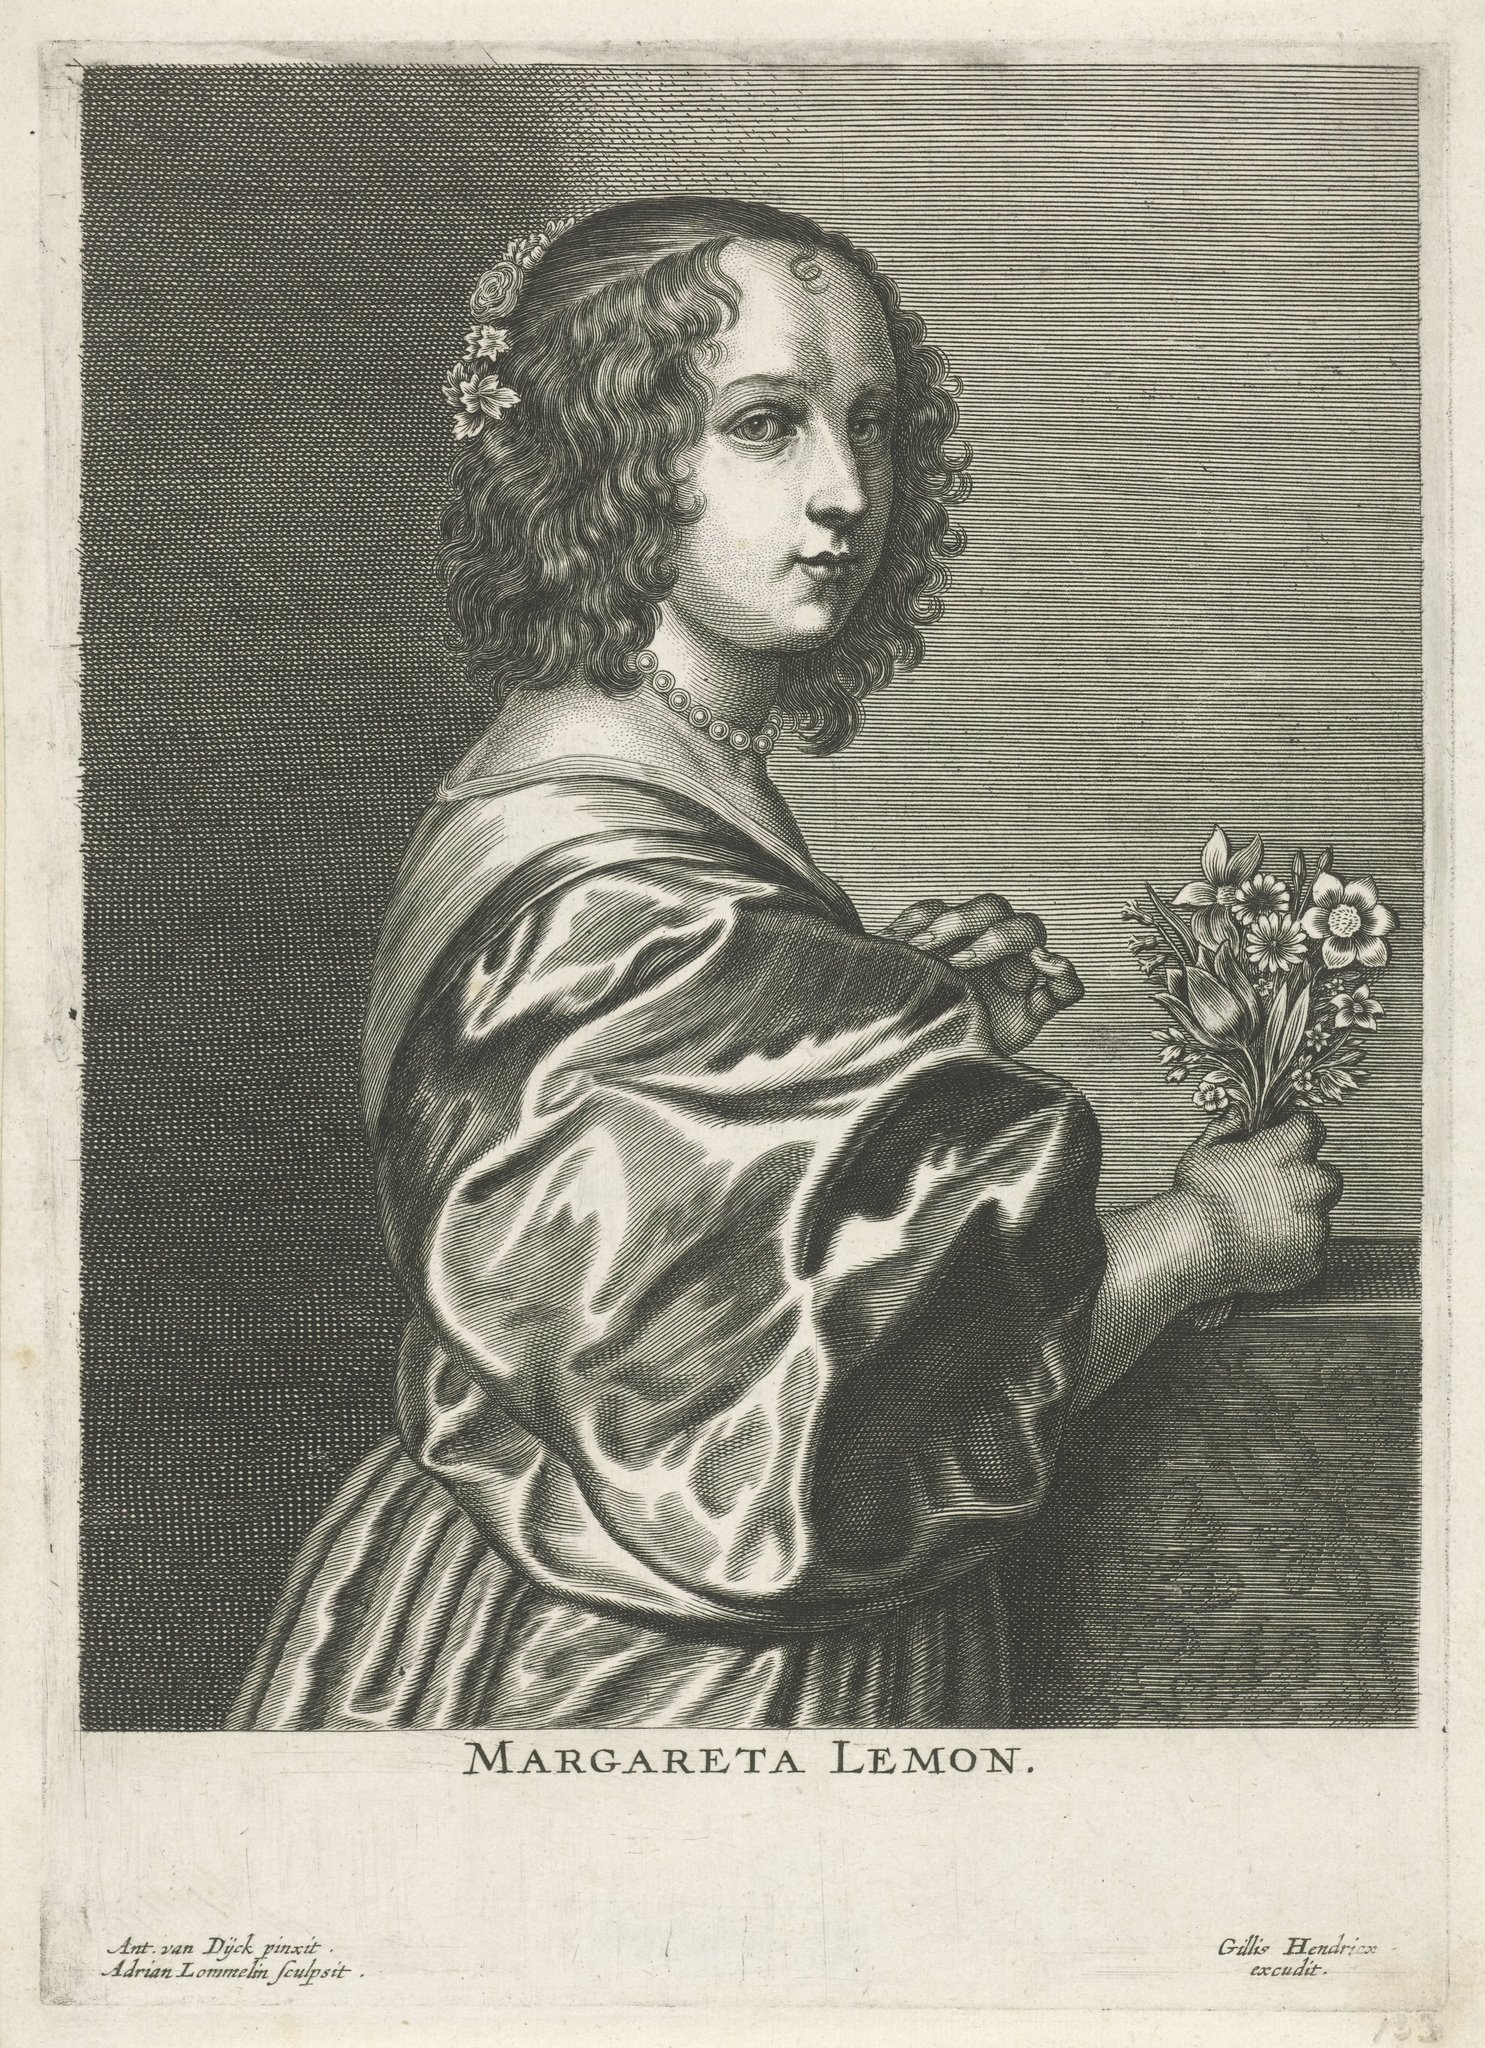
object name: print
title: Portret van Margaret Lemon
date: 1630-1677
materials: paper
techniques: engraving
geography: antwerp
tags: margaret lemon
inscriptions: collector's mark: Lugt 240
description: Portret van Margaret Lemon, model en maîtresse van de schilder Anthony van Dyck.